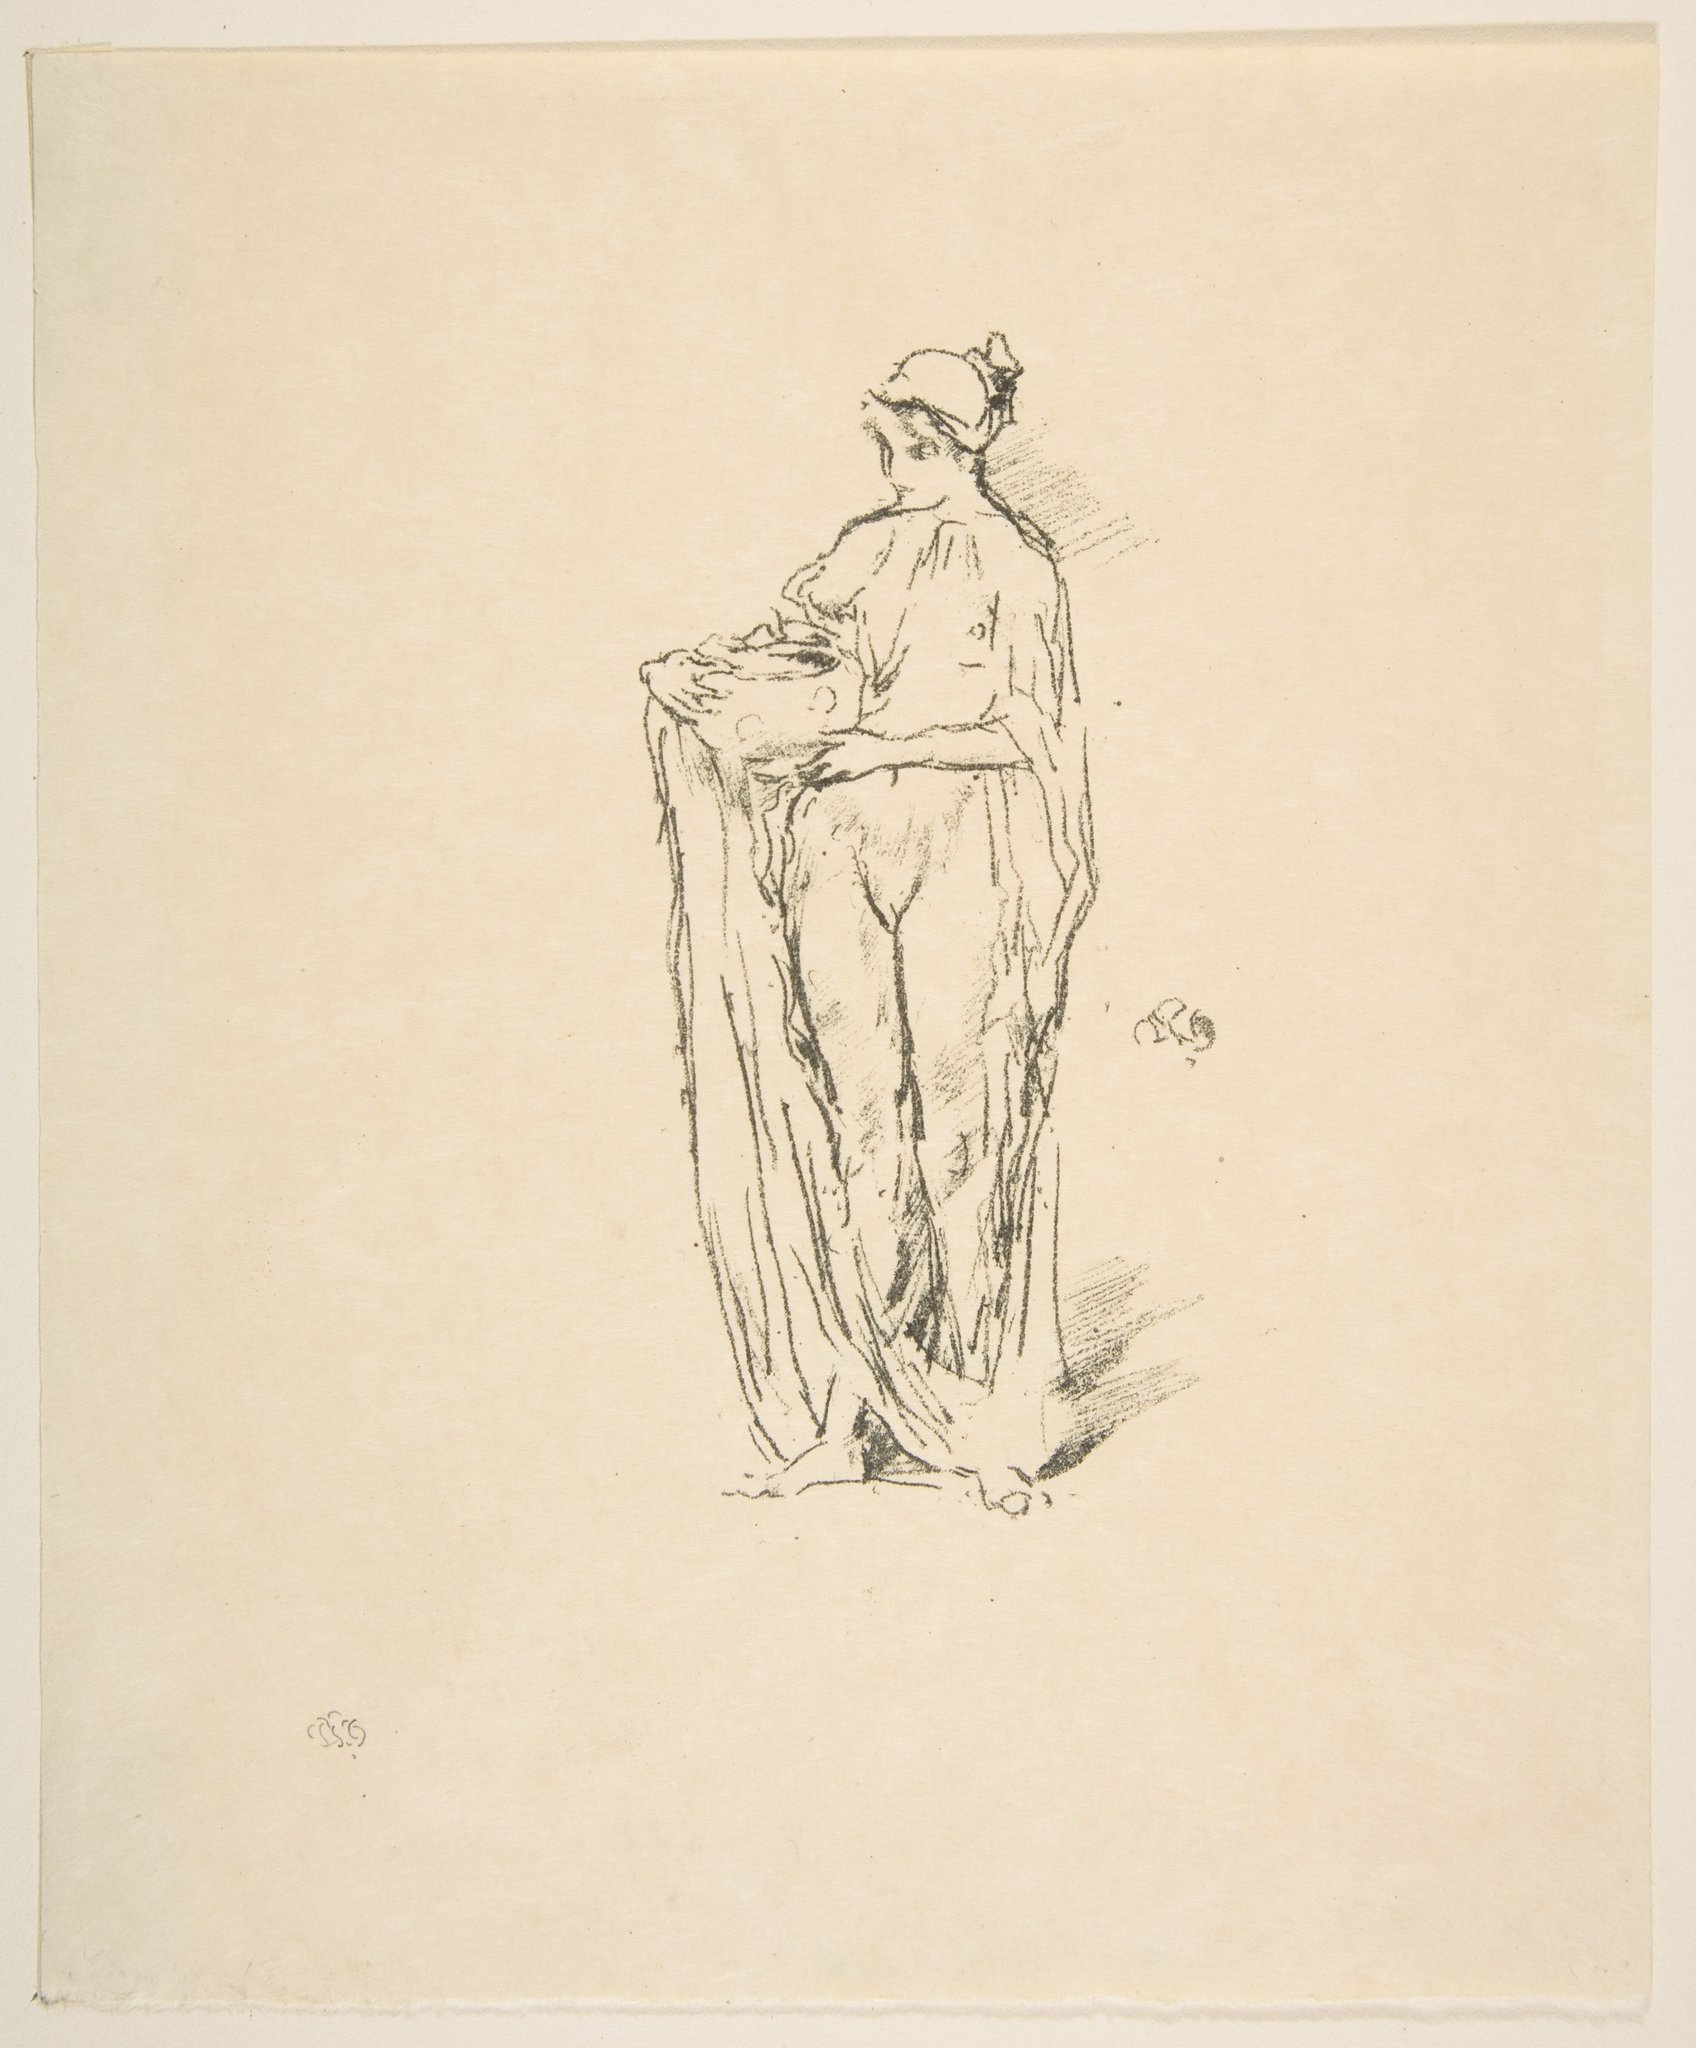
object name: print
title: Girl with a Bowl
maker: james mcneill whistler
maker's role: artist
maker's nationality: american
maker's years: 1834-1903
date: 1895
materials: ink, parchment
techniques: printing, lithography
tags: girls,bowls